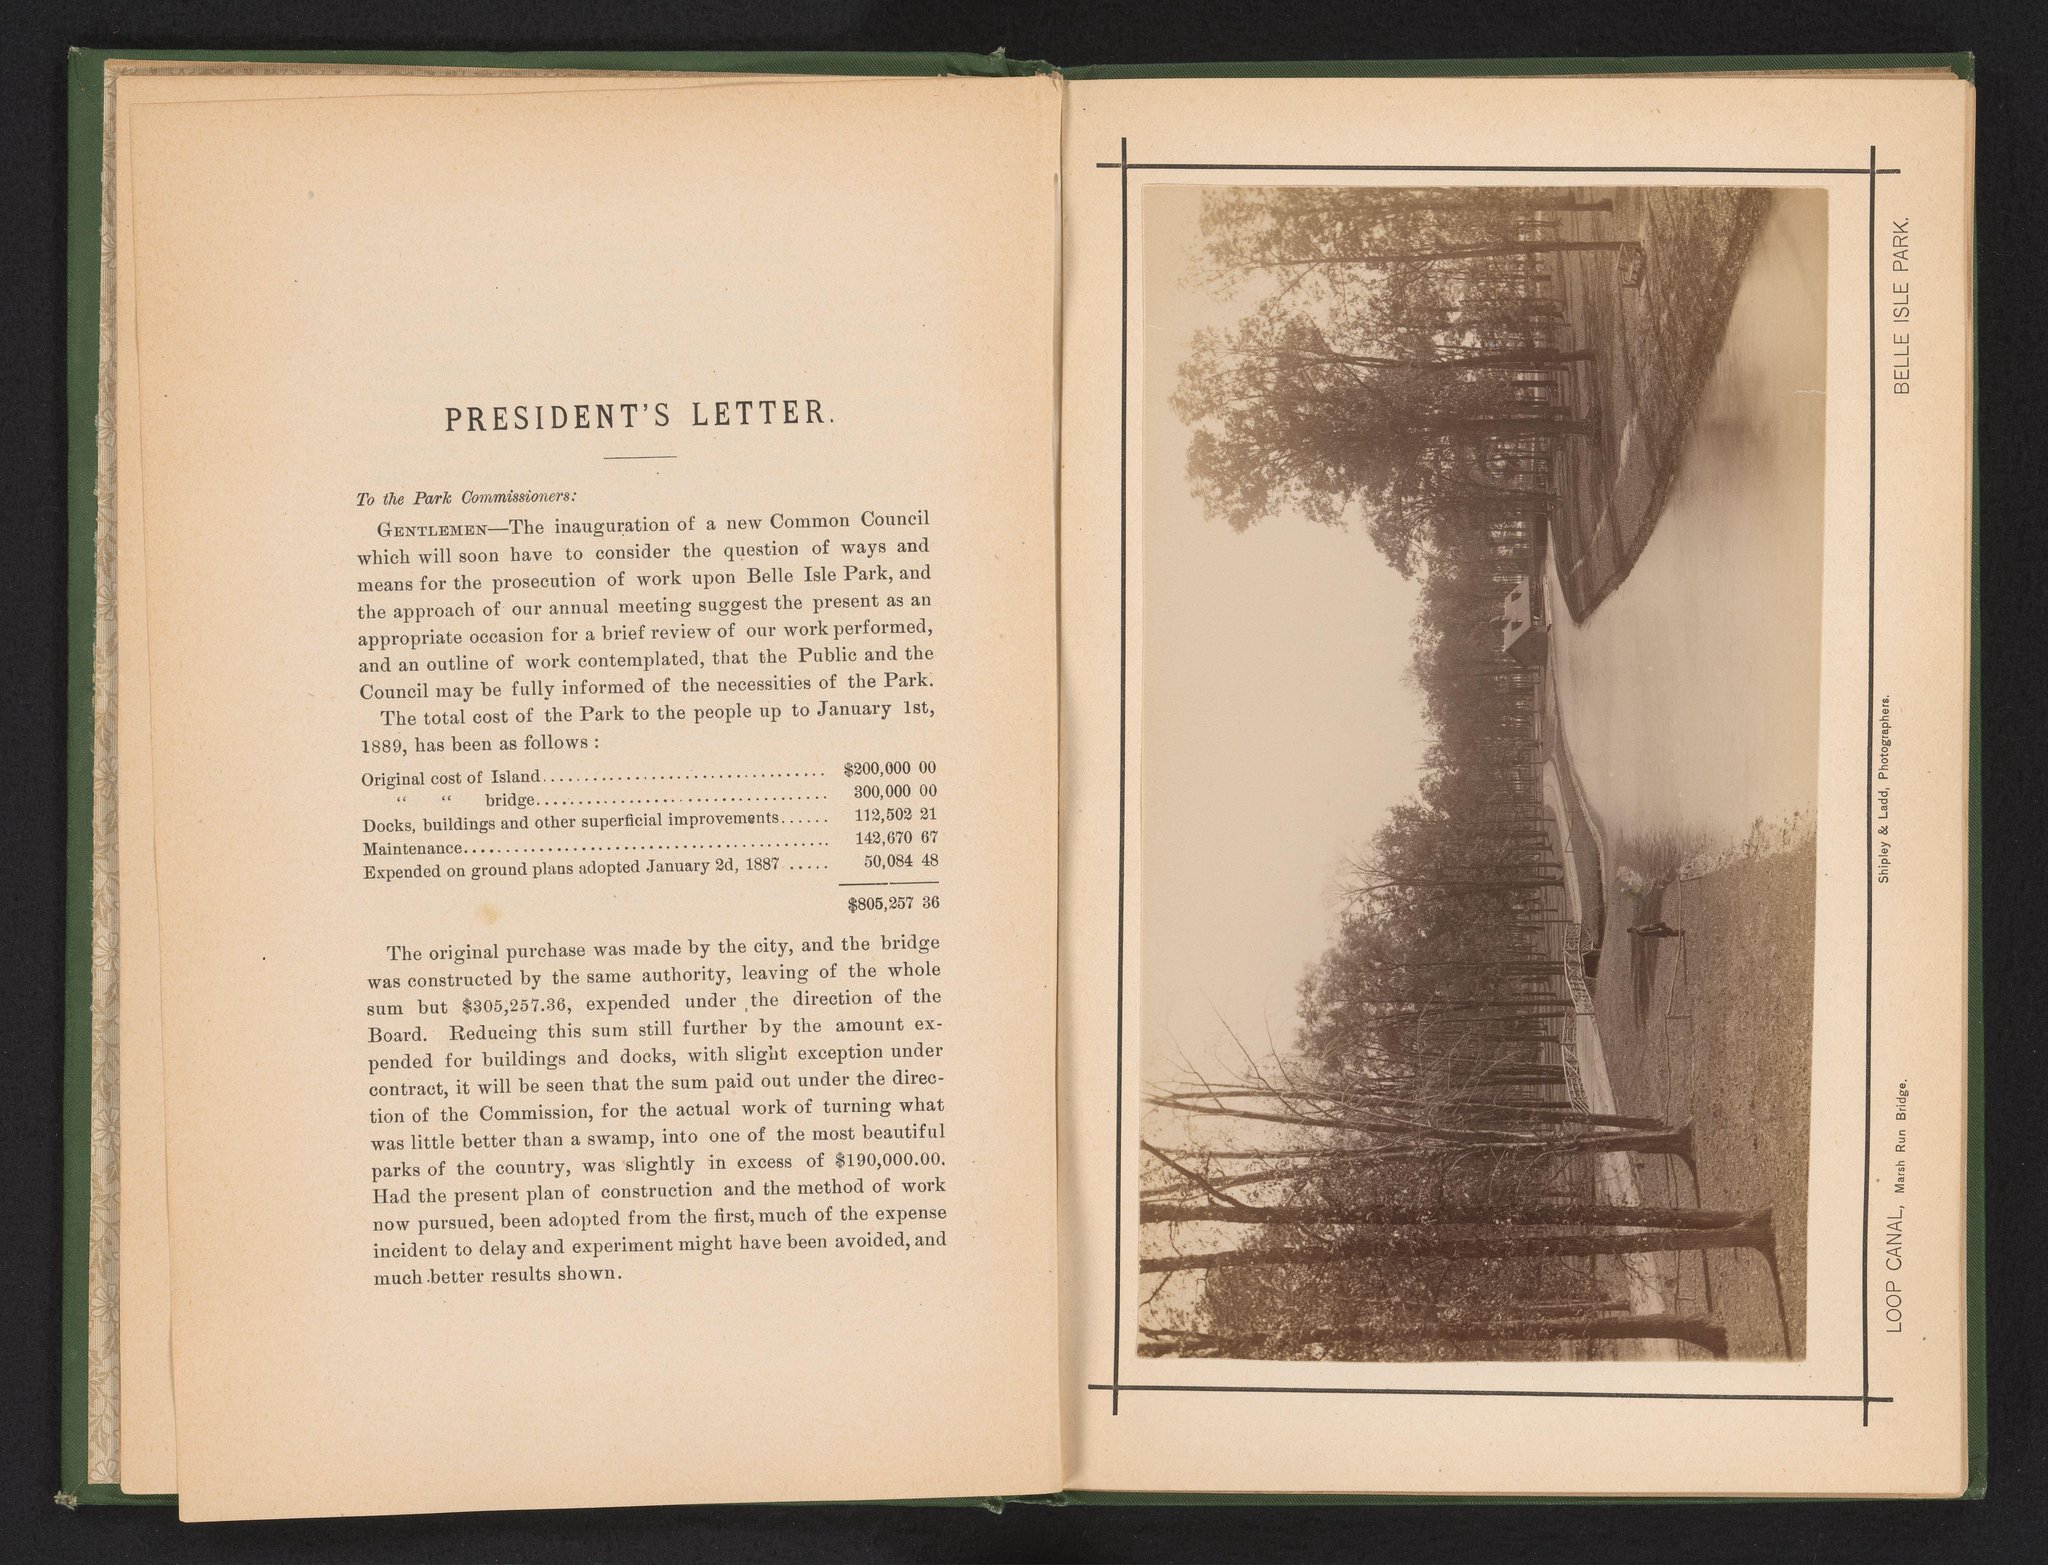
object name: page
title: Belle Isle Park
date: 1879-1889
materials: photographic support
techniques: albumen print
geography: belle isle park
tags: canal, bridge